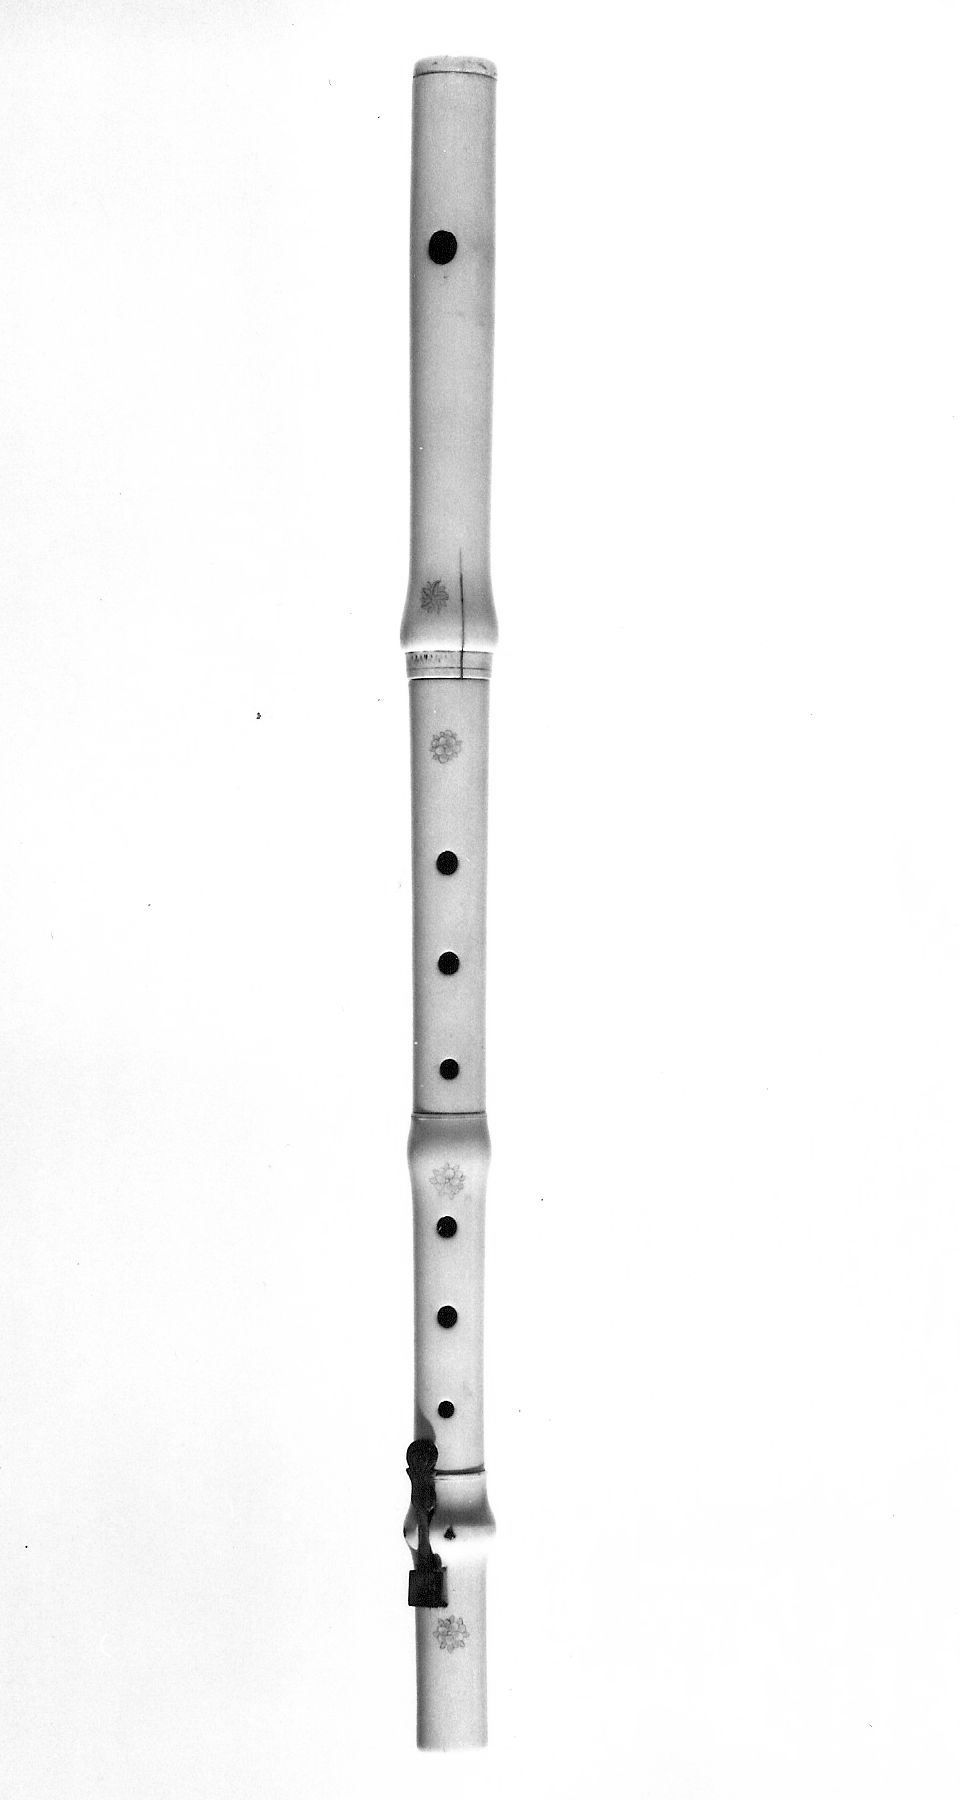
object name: transverse flute in f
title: Transverse Flute in F-sharp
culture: french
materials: ivory, silver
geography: france